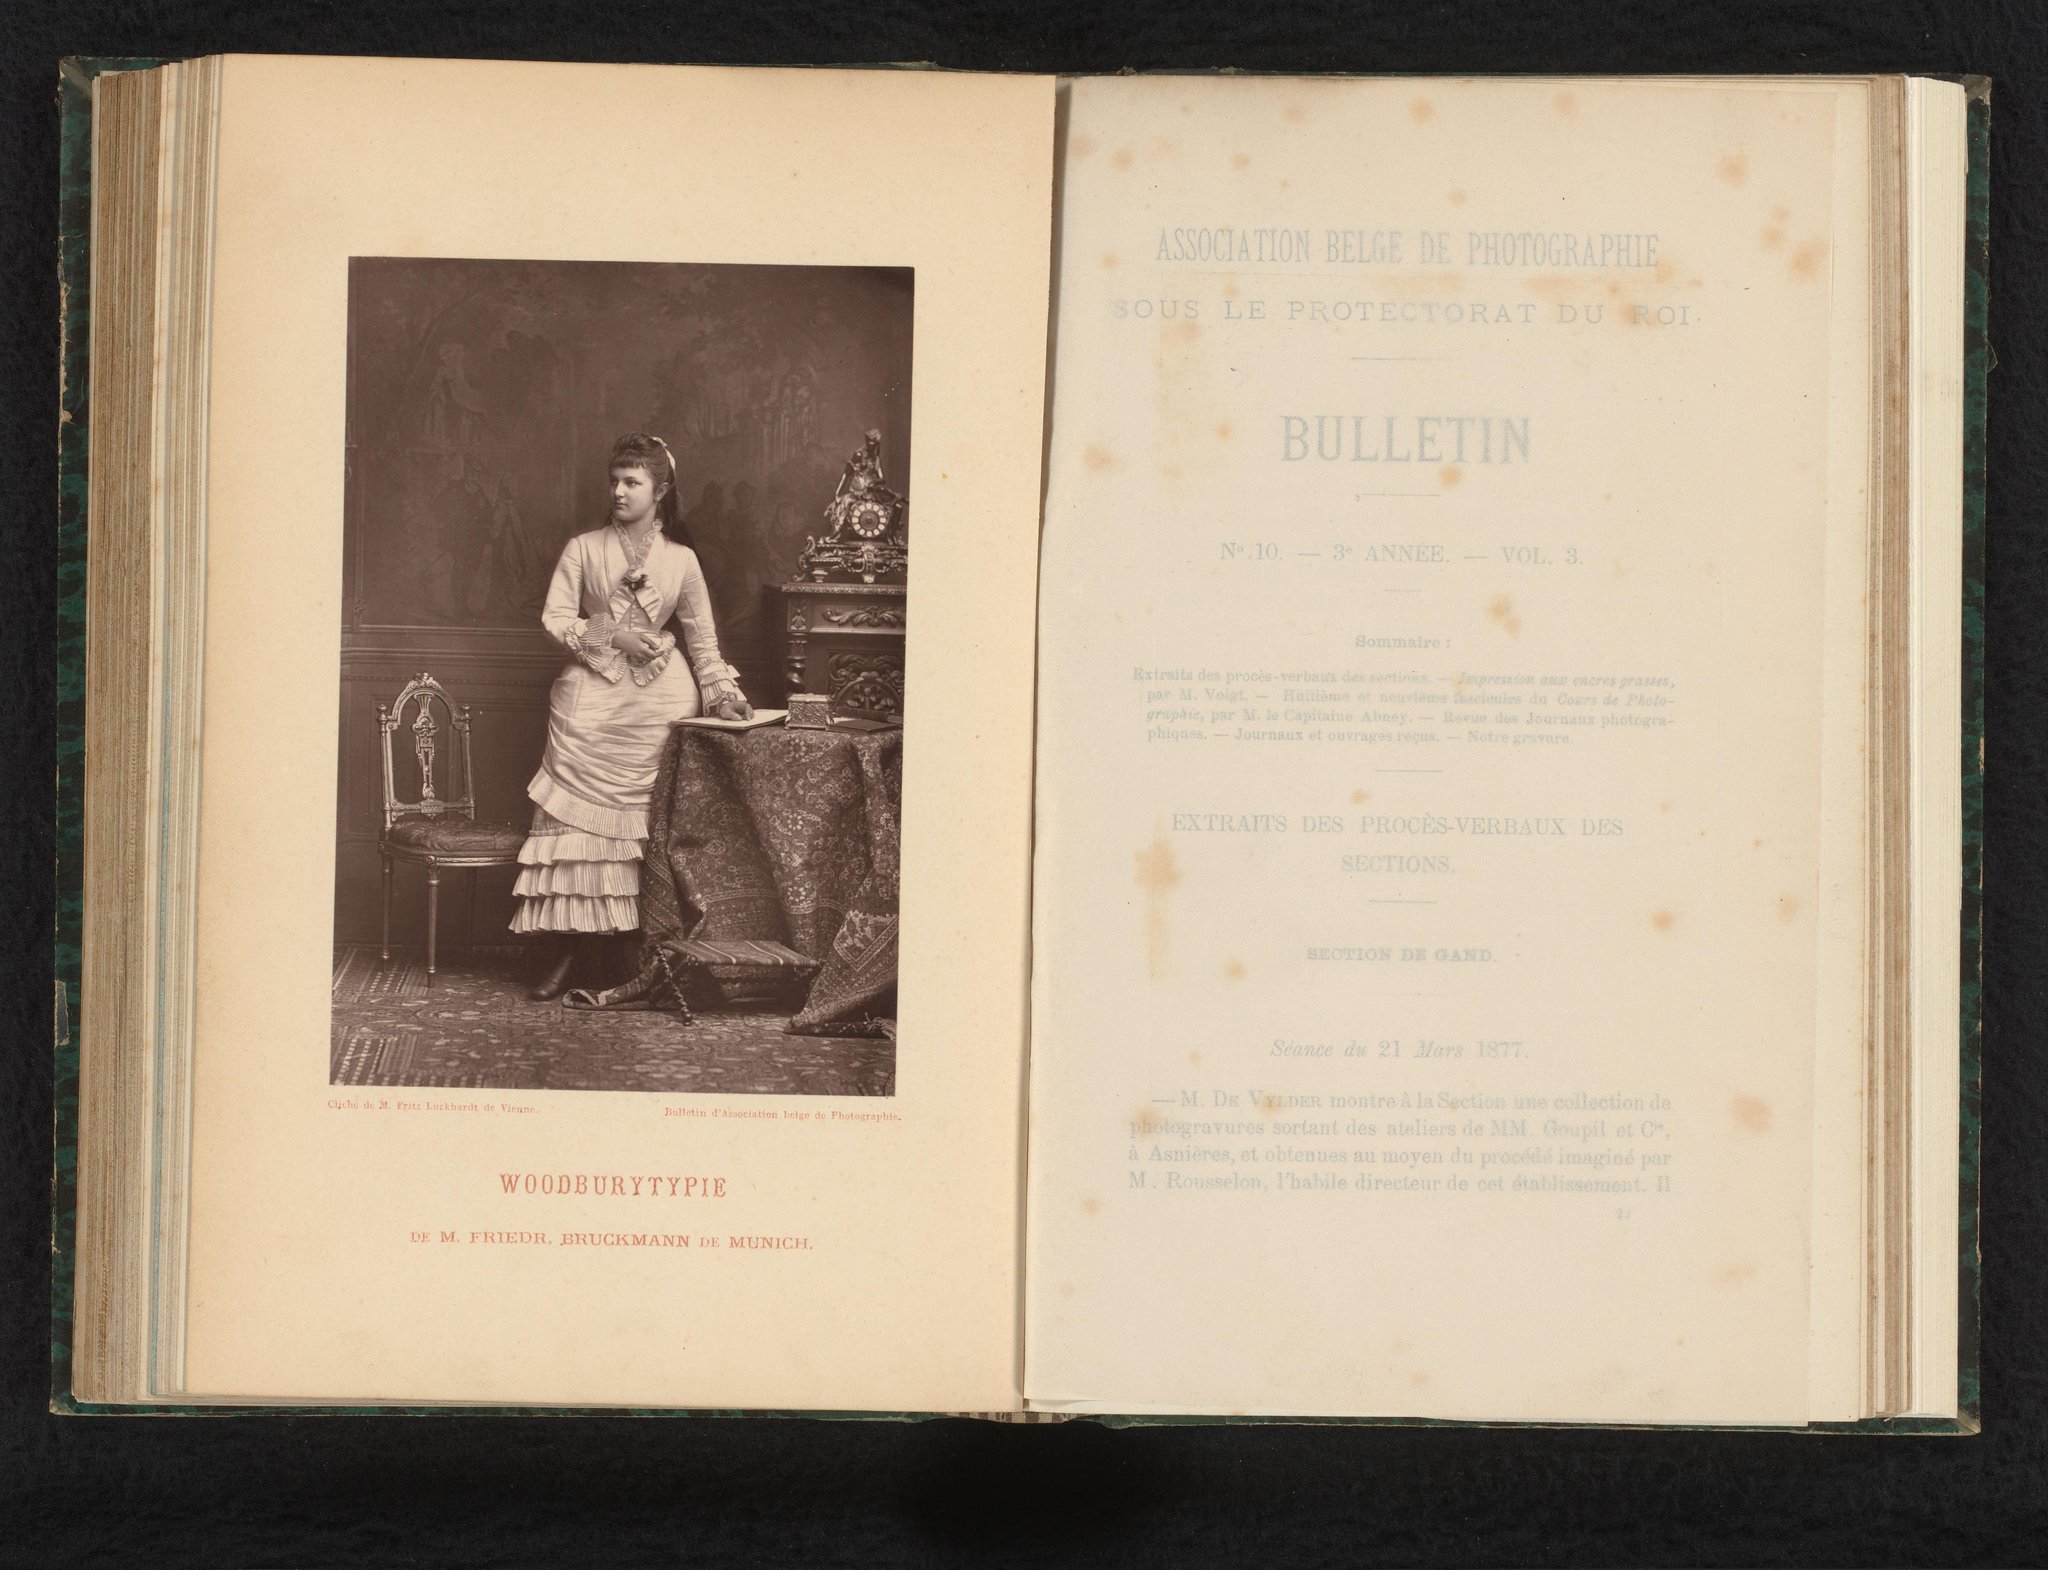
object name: page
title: Portret van een onbekende staande vrouw aan een tafel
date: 1876-1877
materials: paper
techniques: woodburytype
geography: munich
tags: adult woman, historical persons not known by name - bb - woman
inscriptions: inscription: ‘Woodburytypie’